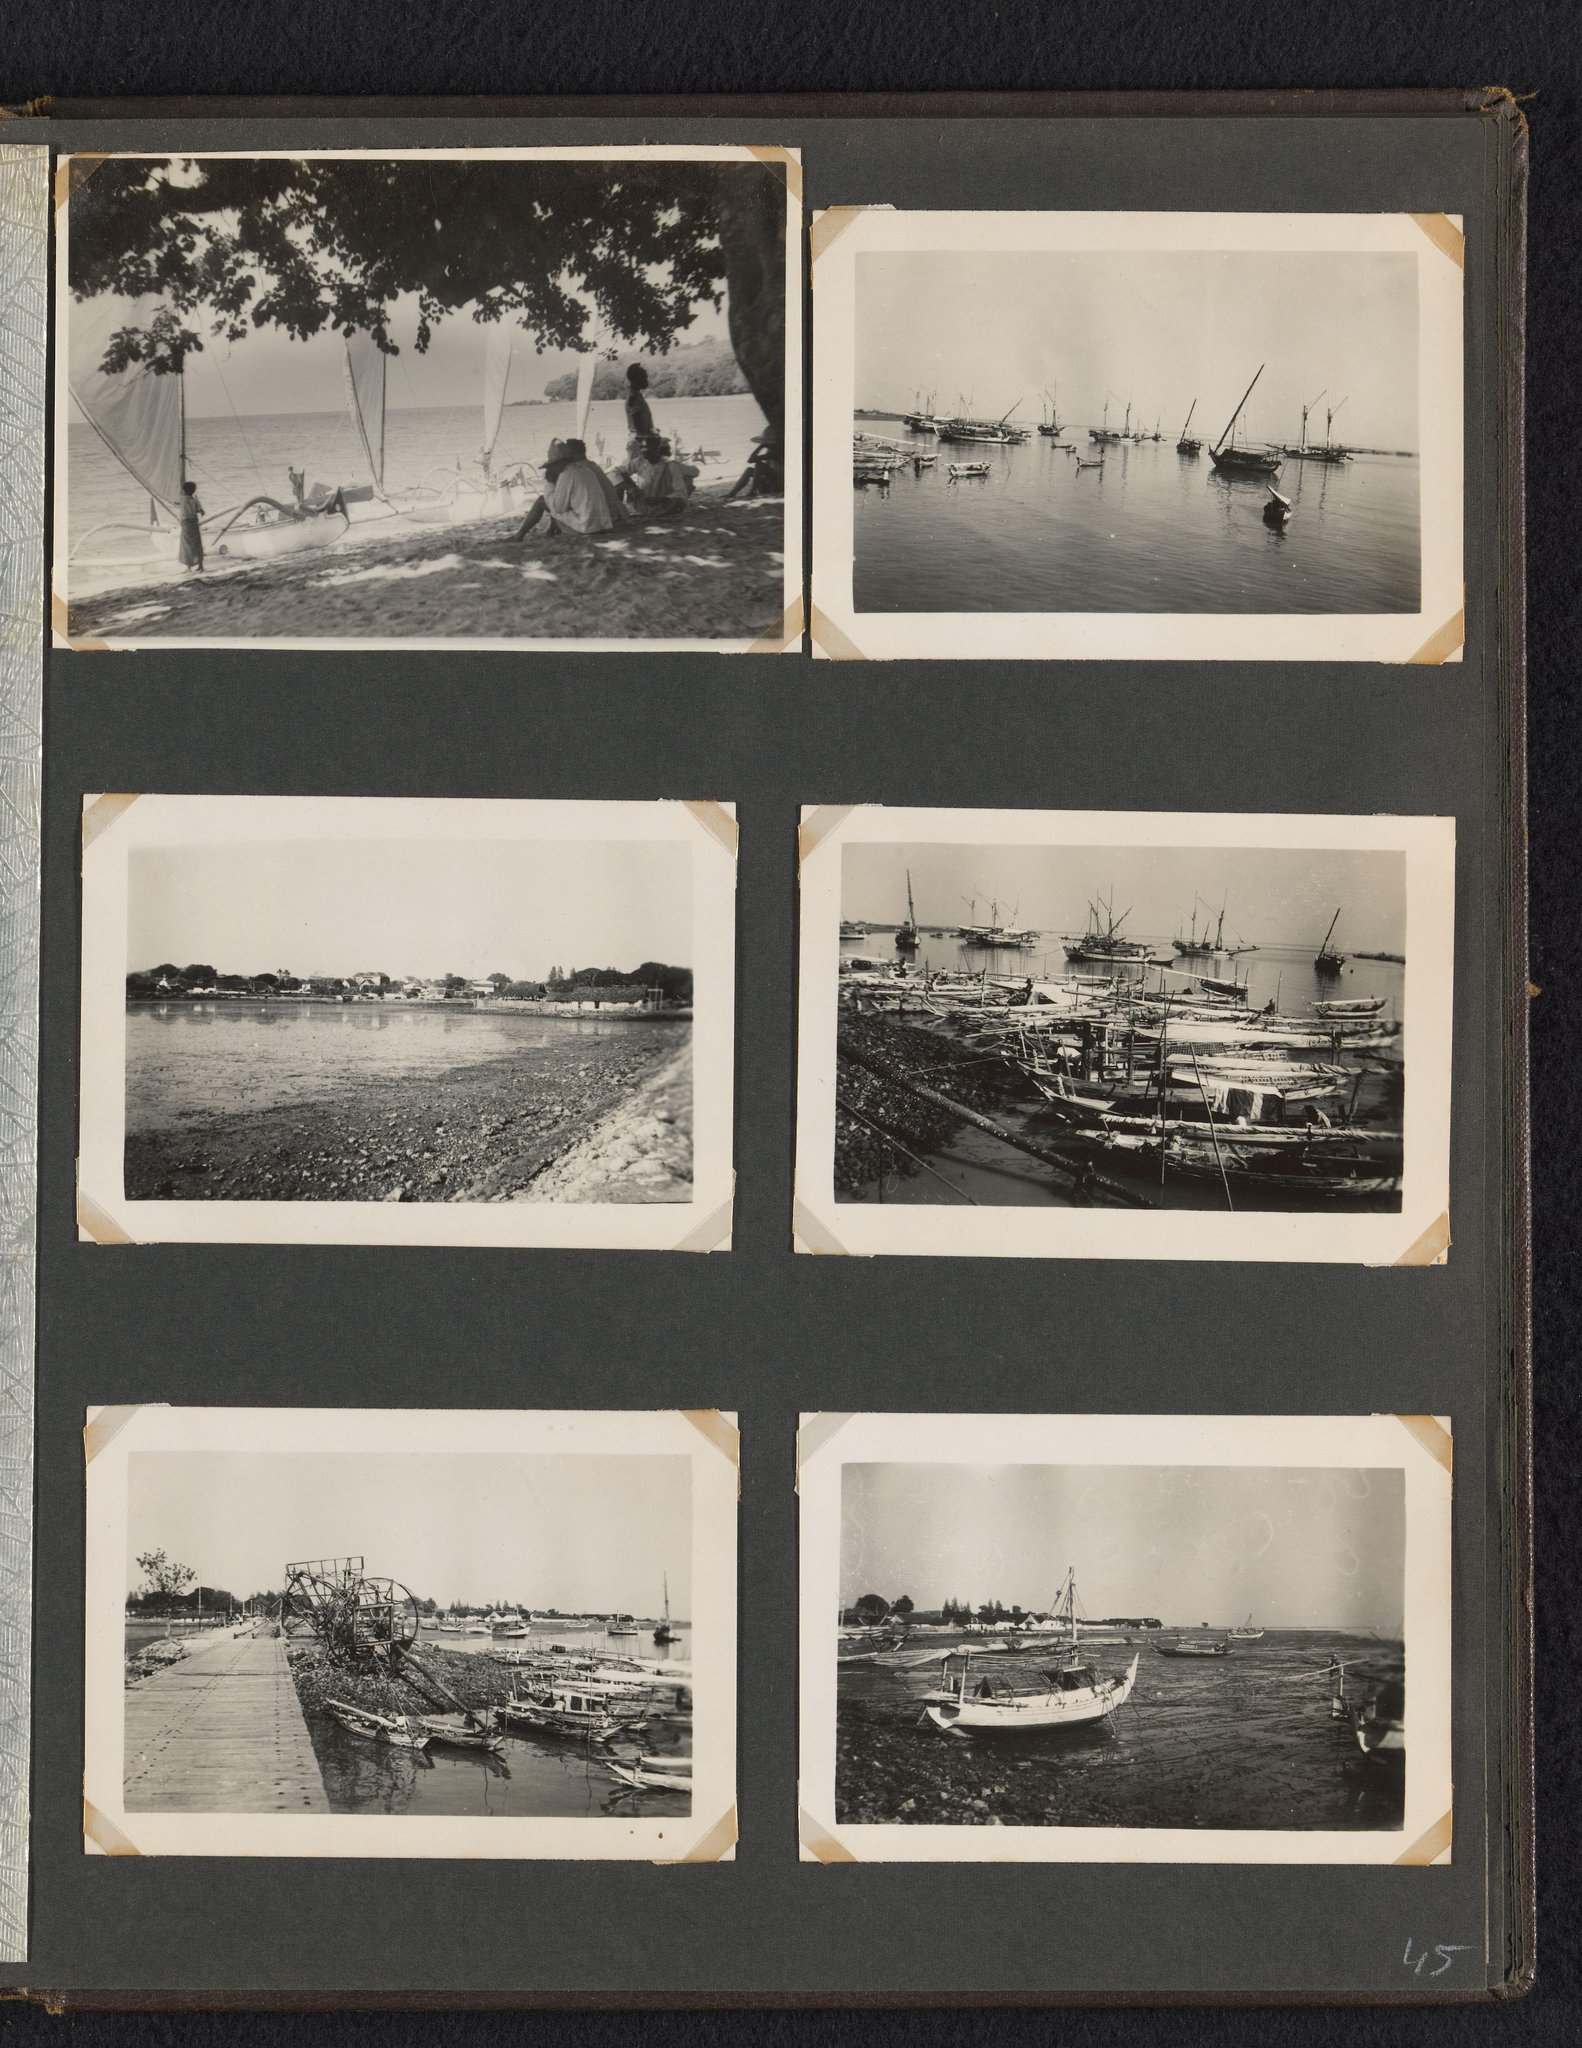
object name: album leaf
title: Pasir Putih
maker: Anonymous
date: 1949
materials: cardboard, photographic support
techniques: gelatin silver print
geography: dutch east indies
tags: landscapes in tropical and sub-tropical regions, dutch east indies, the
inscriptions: inscription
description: Albumblad met zes foto's gezichten van de kustplaats Pasir Putih (Pasir Poetih) in Oost-Java. Onderdeel van het fotoalbum 'Mijn jaren in Indië' met foto's over de militaire acties in Nederlands-Indië.